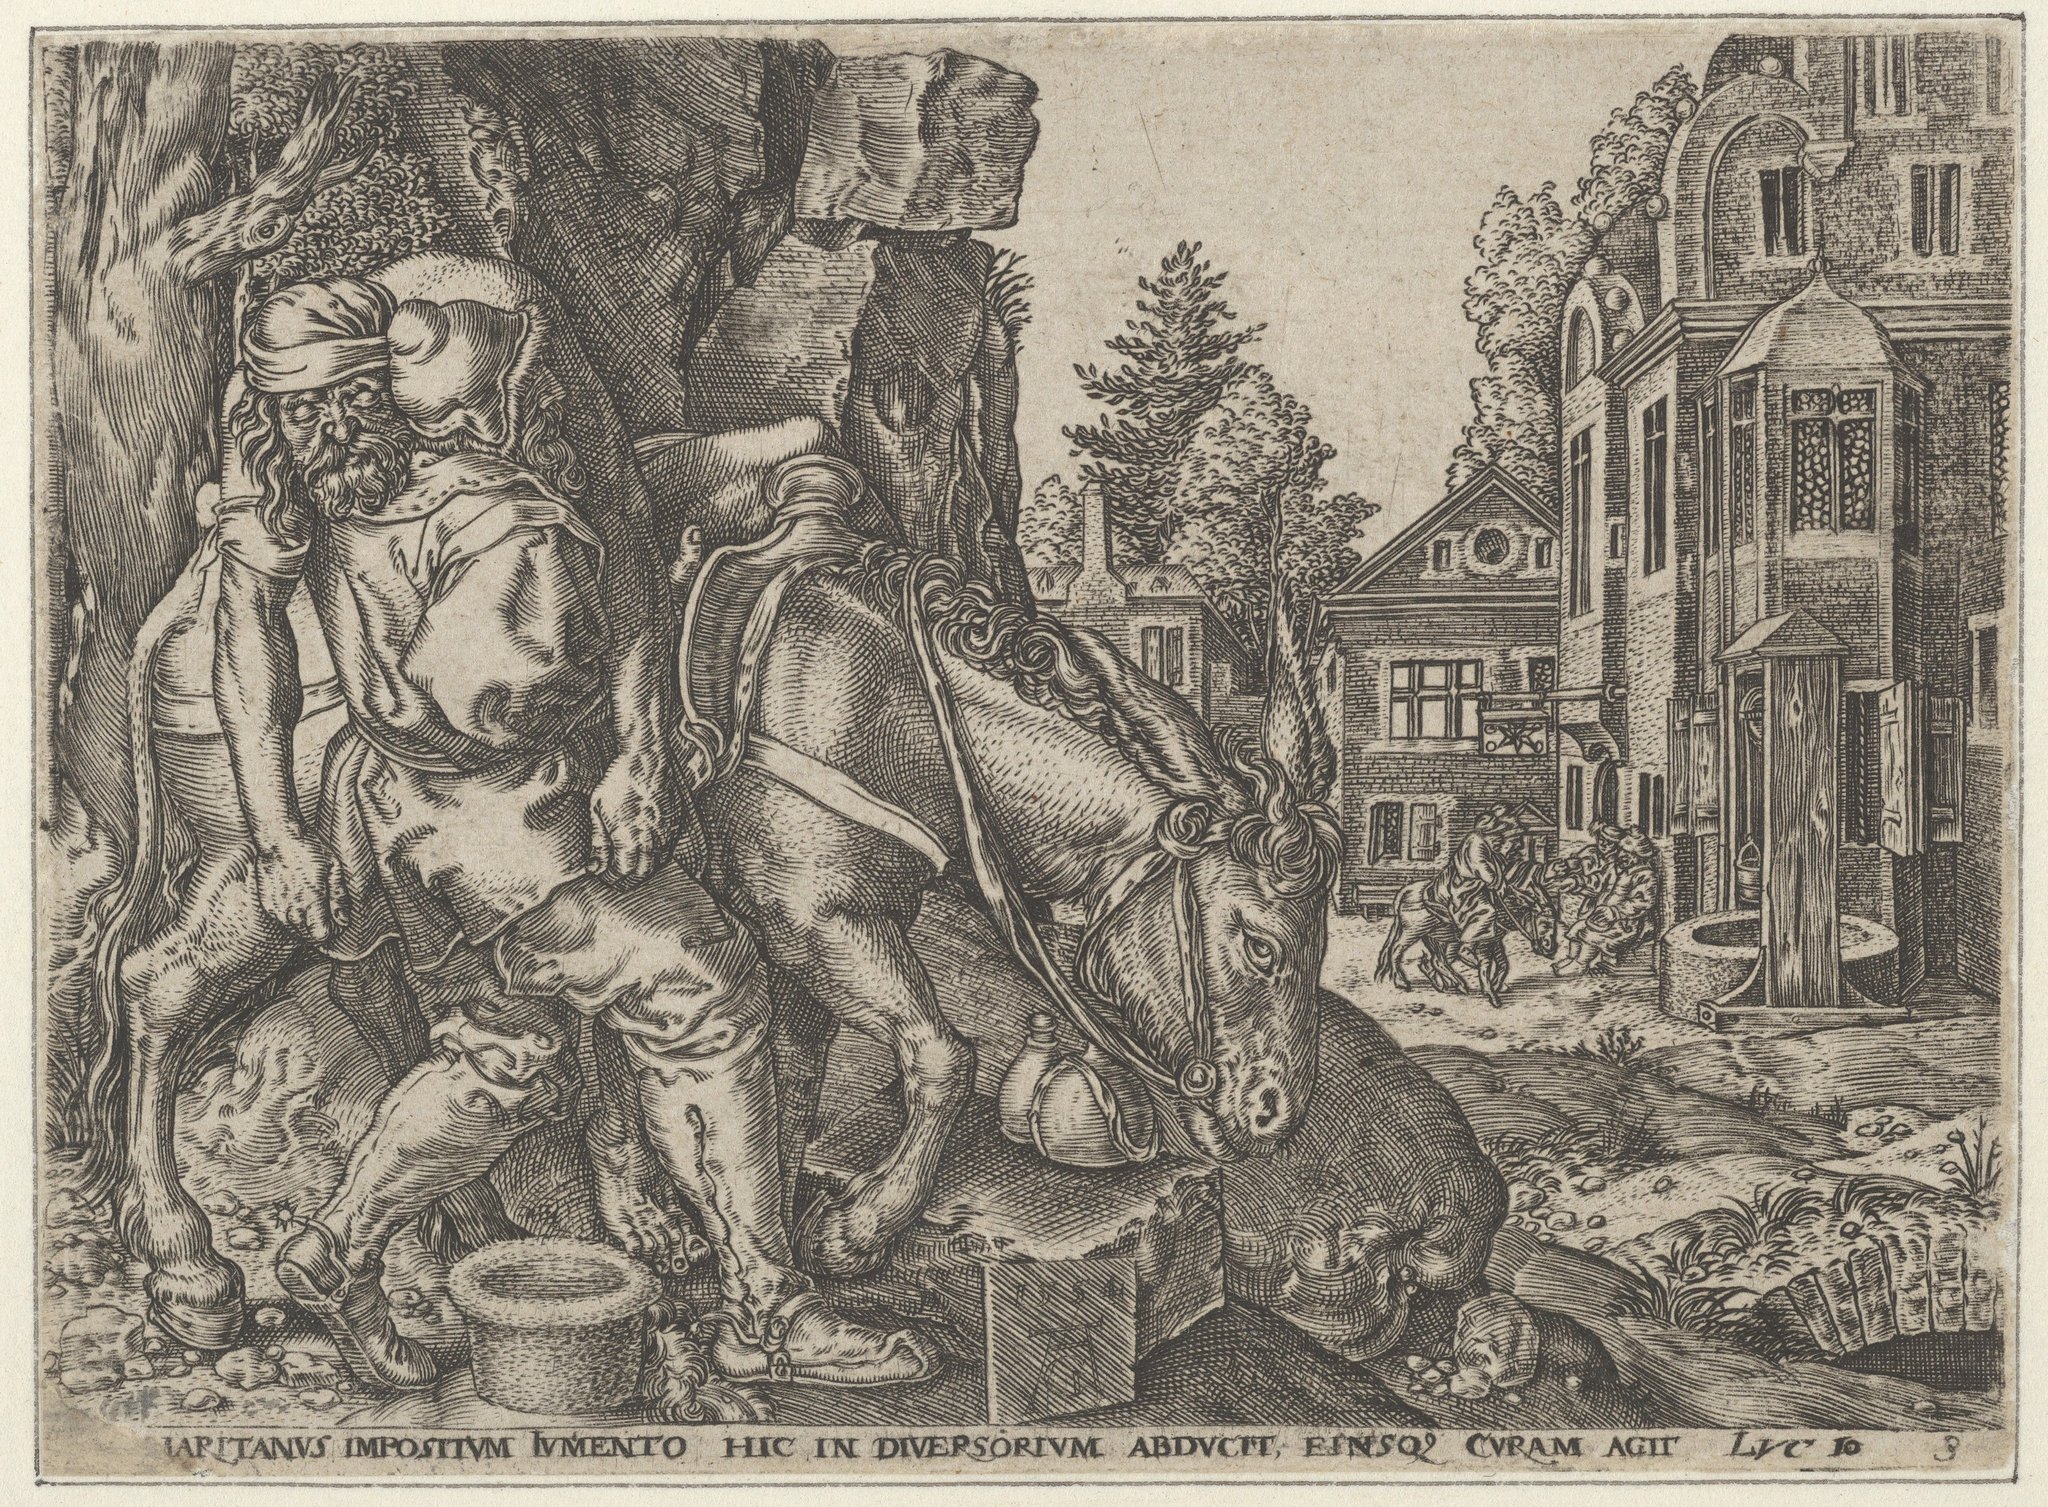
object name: print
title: Copy of The Good Samaritan Putting the Traveller on His Donkey, from The Parable of the Good Samaritan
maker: Anonymous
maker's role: artist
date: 1554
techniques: engraving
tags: buildings,men,donkeys